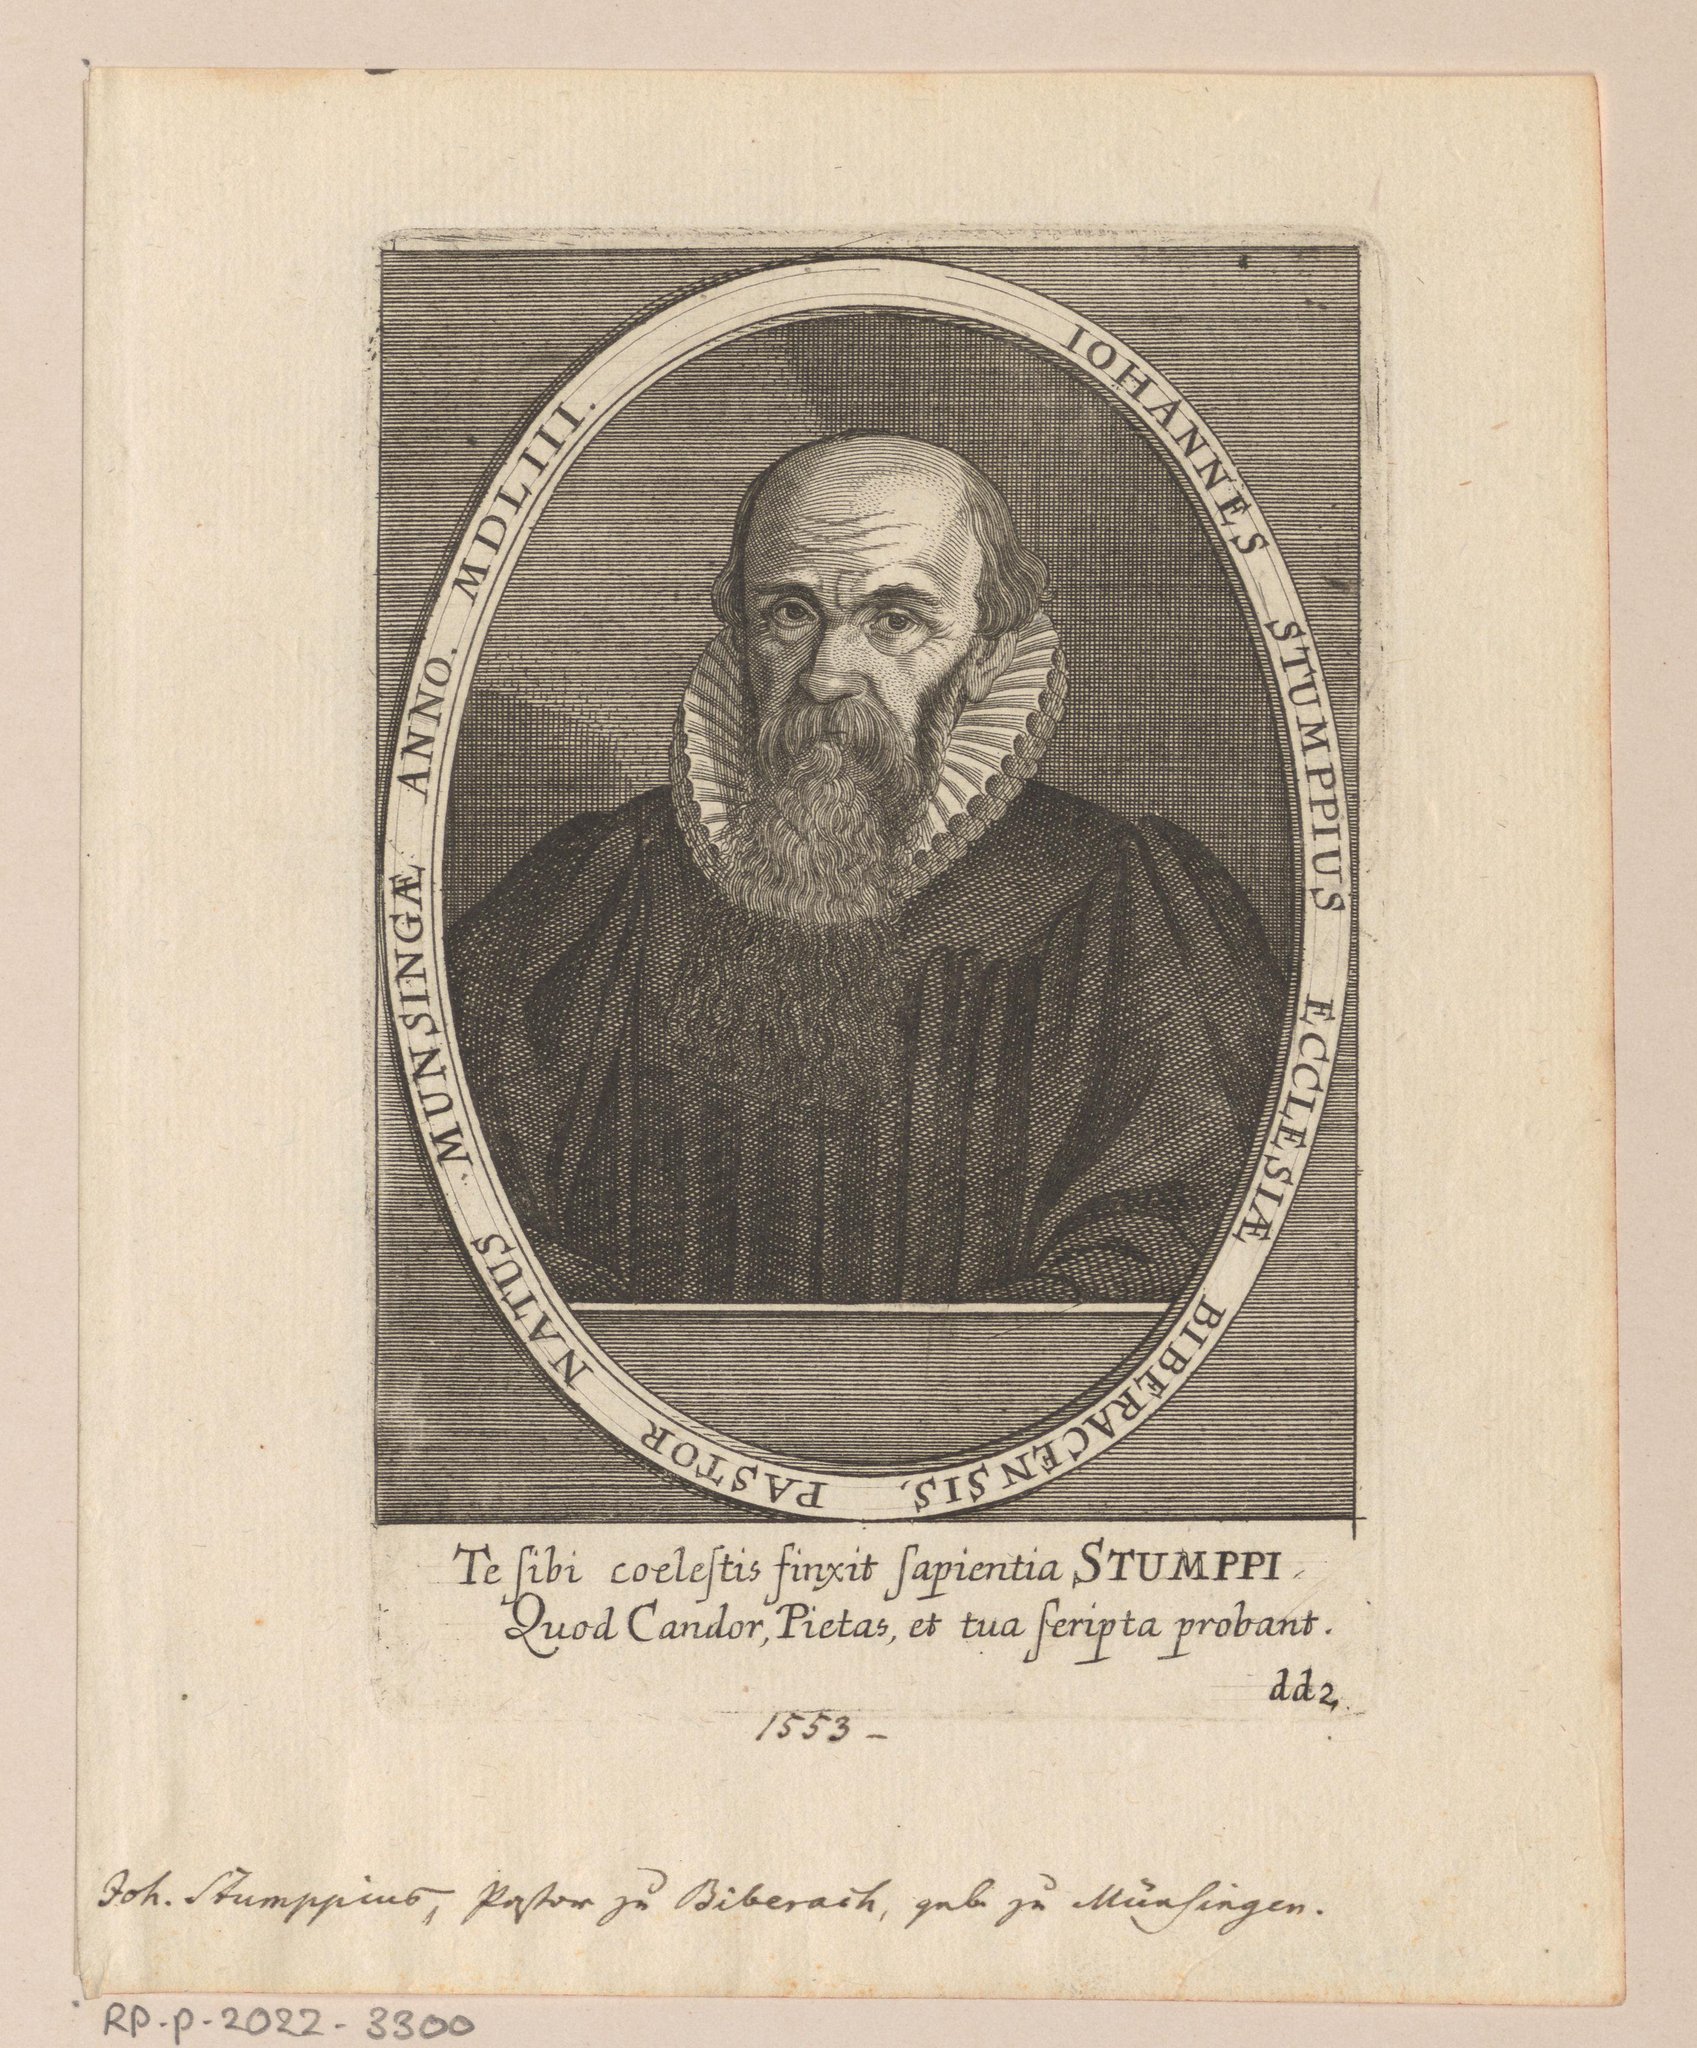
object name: print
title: Portret van Johannes Stumpf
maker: Anonymous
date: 1553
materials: paper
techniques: etching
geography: germany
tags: theologian, historical persons